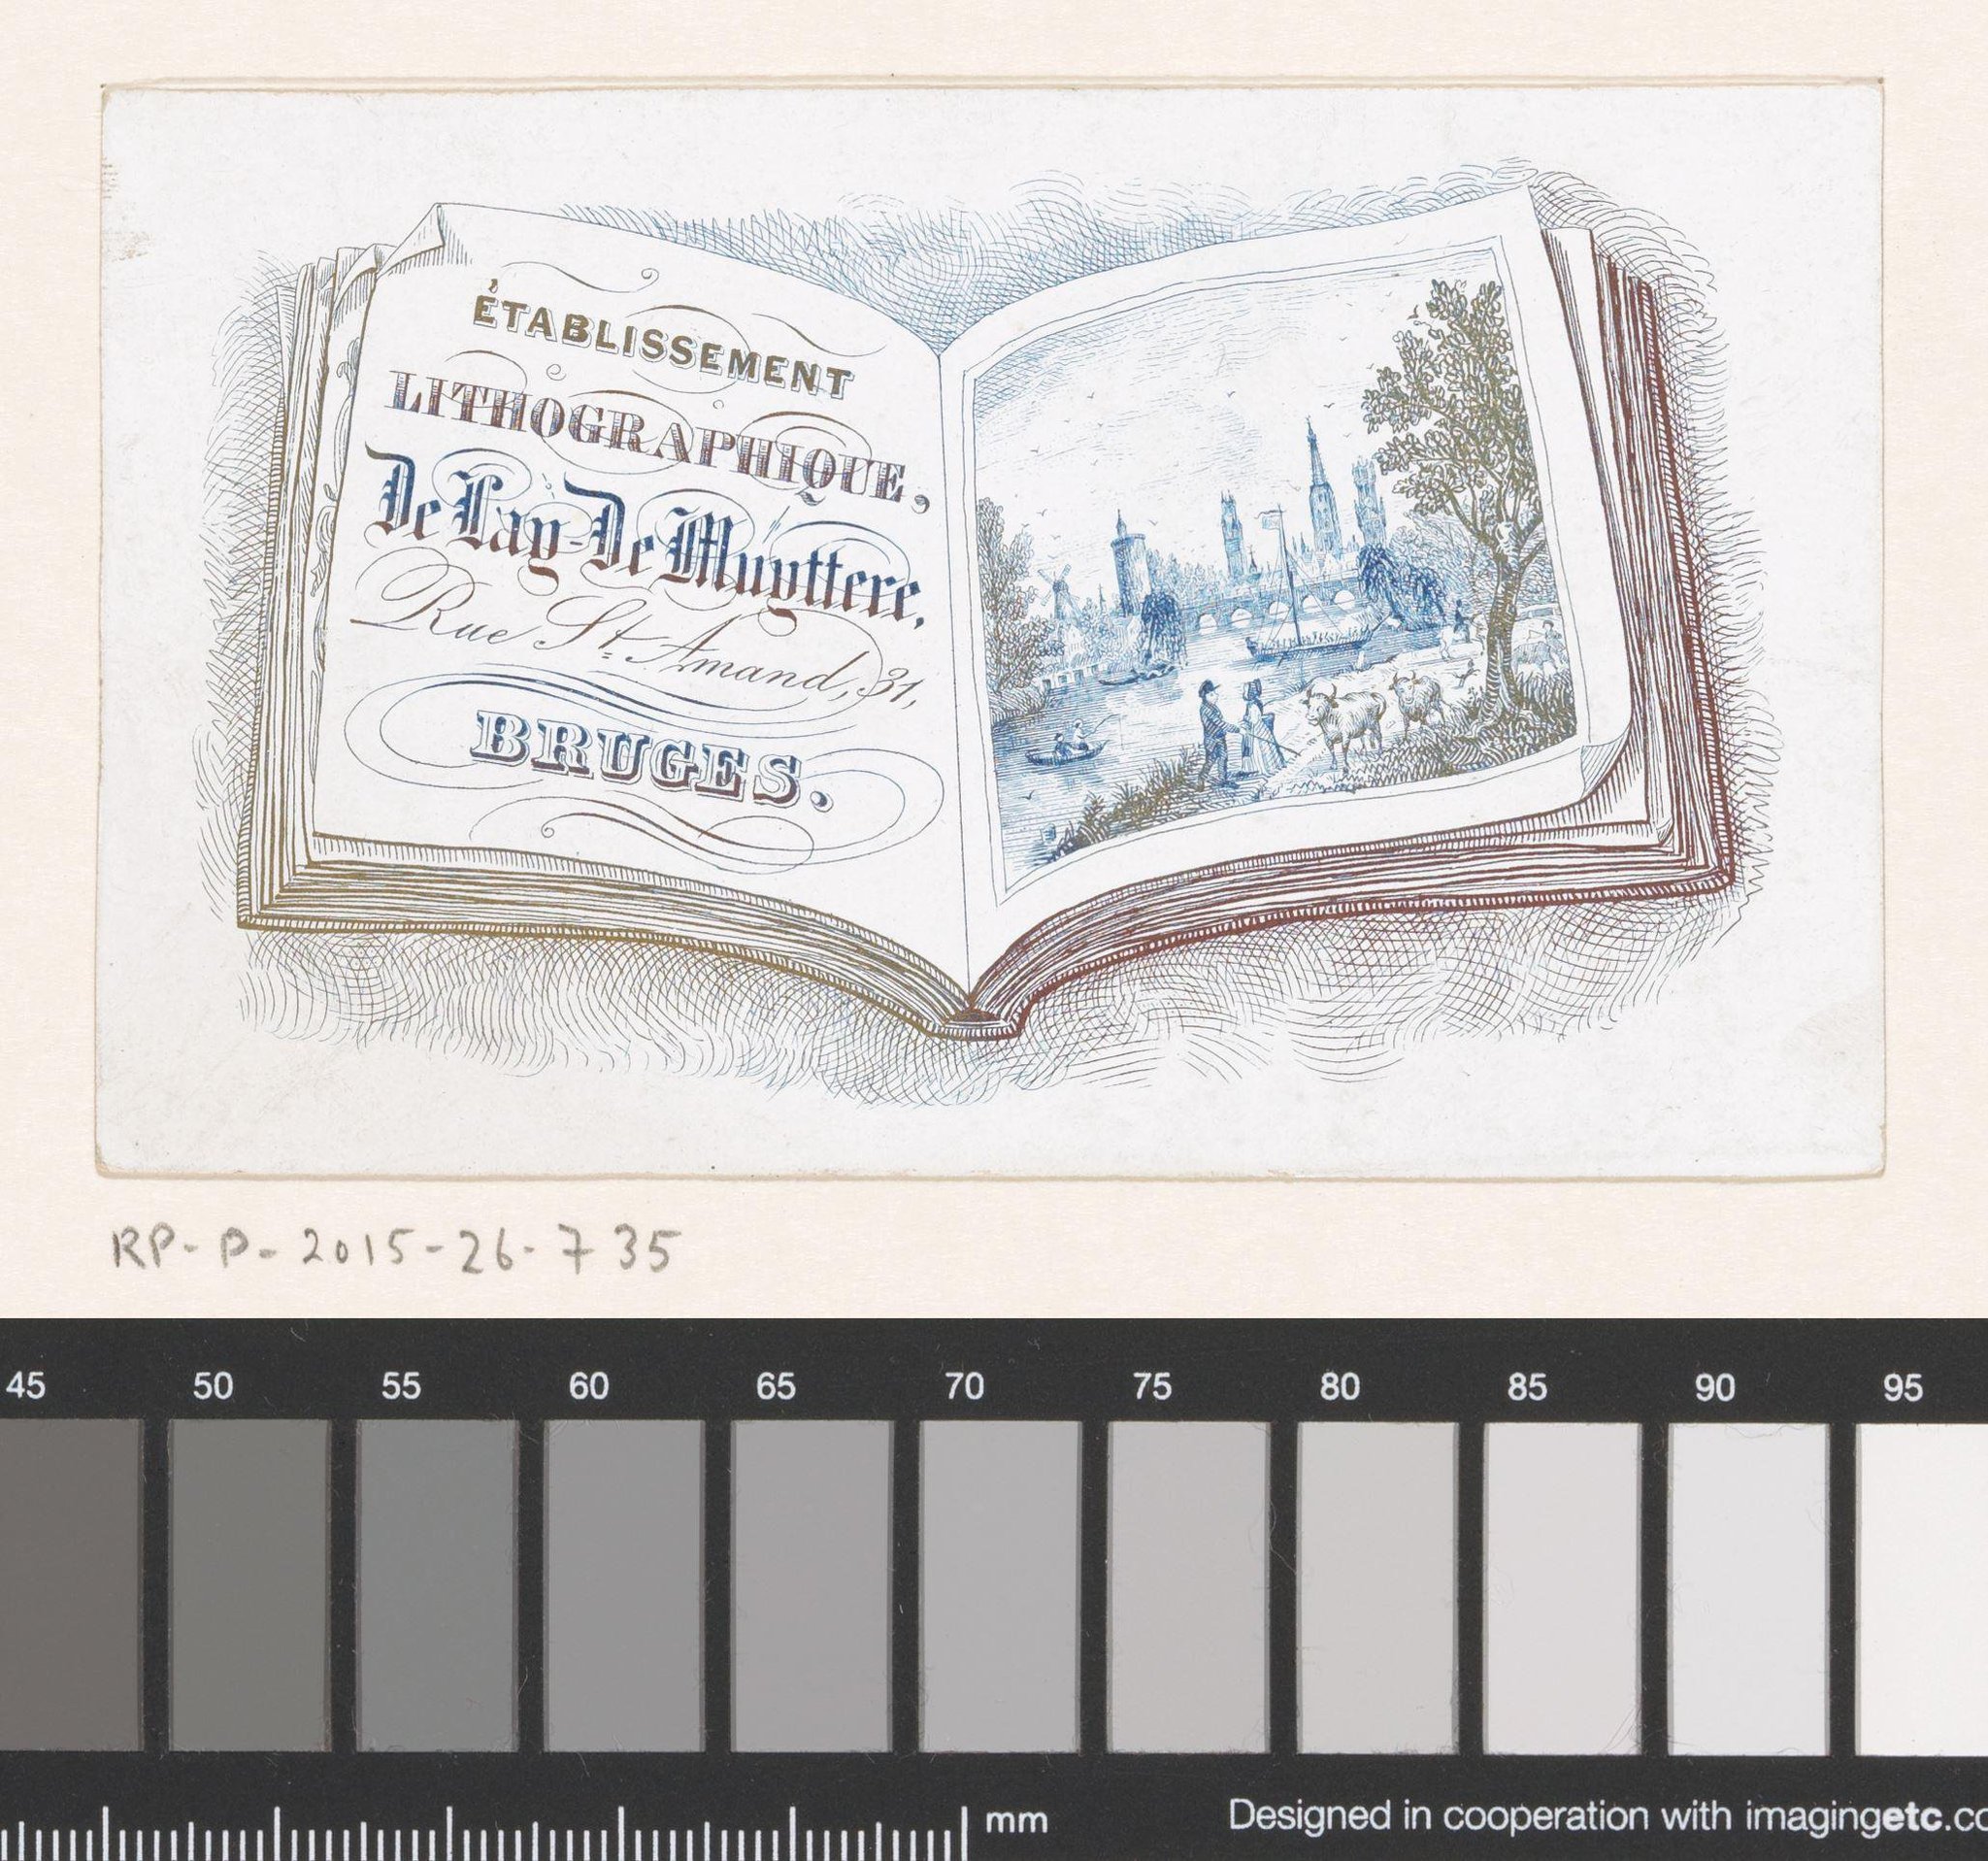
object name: print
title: Visitekaartje van drukker Édouard De Lay De Muyttere te Brugge.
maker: édouard de lay-de muyttere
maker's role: print maker, printer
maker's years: 1816-1857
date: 1842-1857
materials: porcelainized cardboard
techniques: lithograph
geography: bruges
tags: city-view in general; 'veduta', book in which illustrations are essential - mm - book open, bruges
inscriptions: collector's mark: Lugt 2228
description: Opengeslagen boek met op de rechterpagina een gezicht op Brugge met de Minnewaterbrug in de voorgrond.